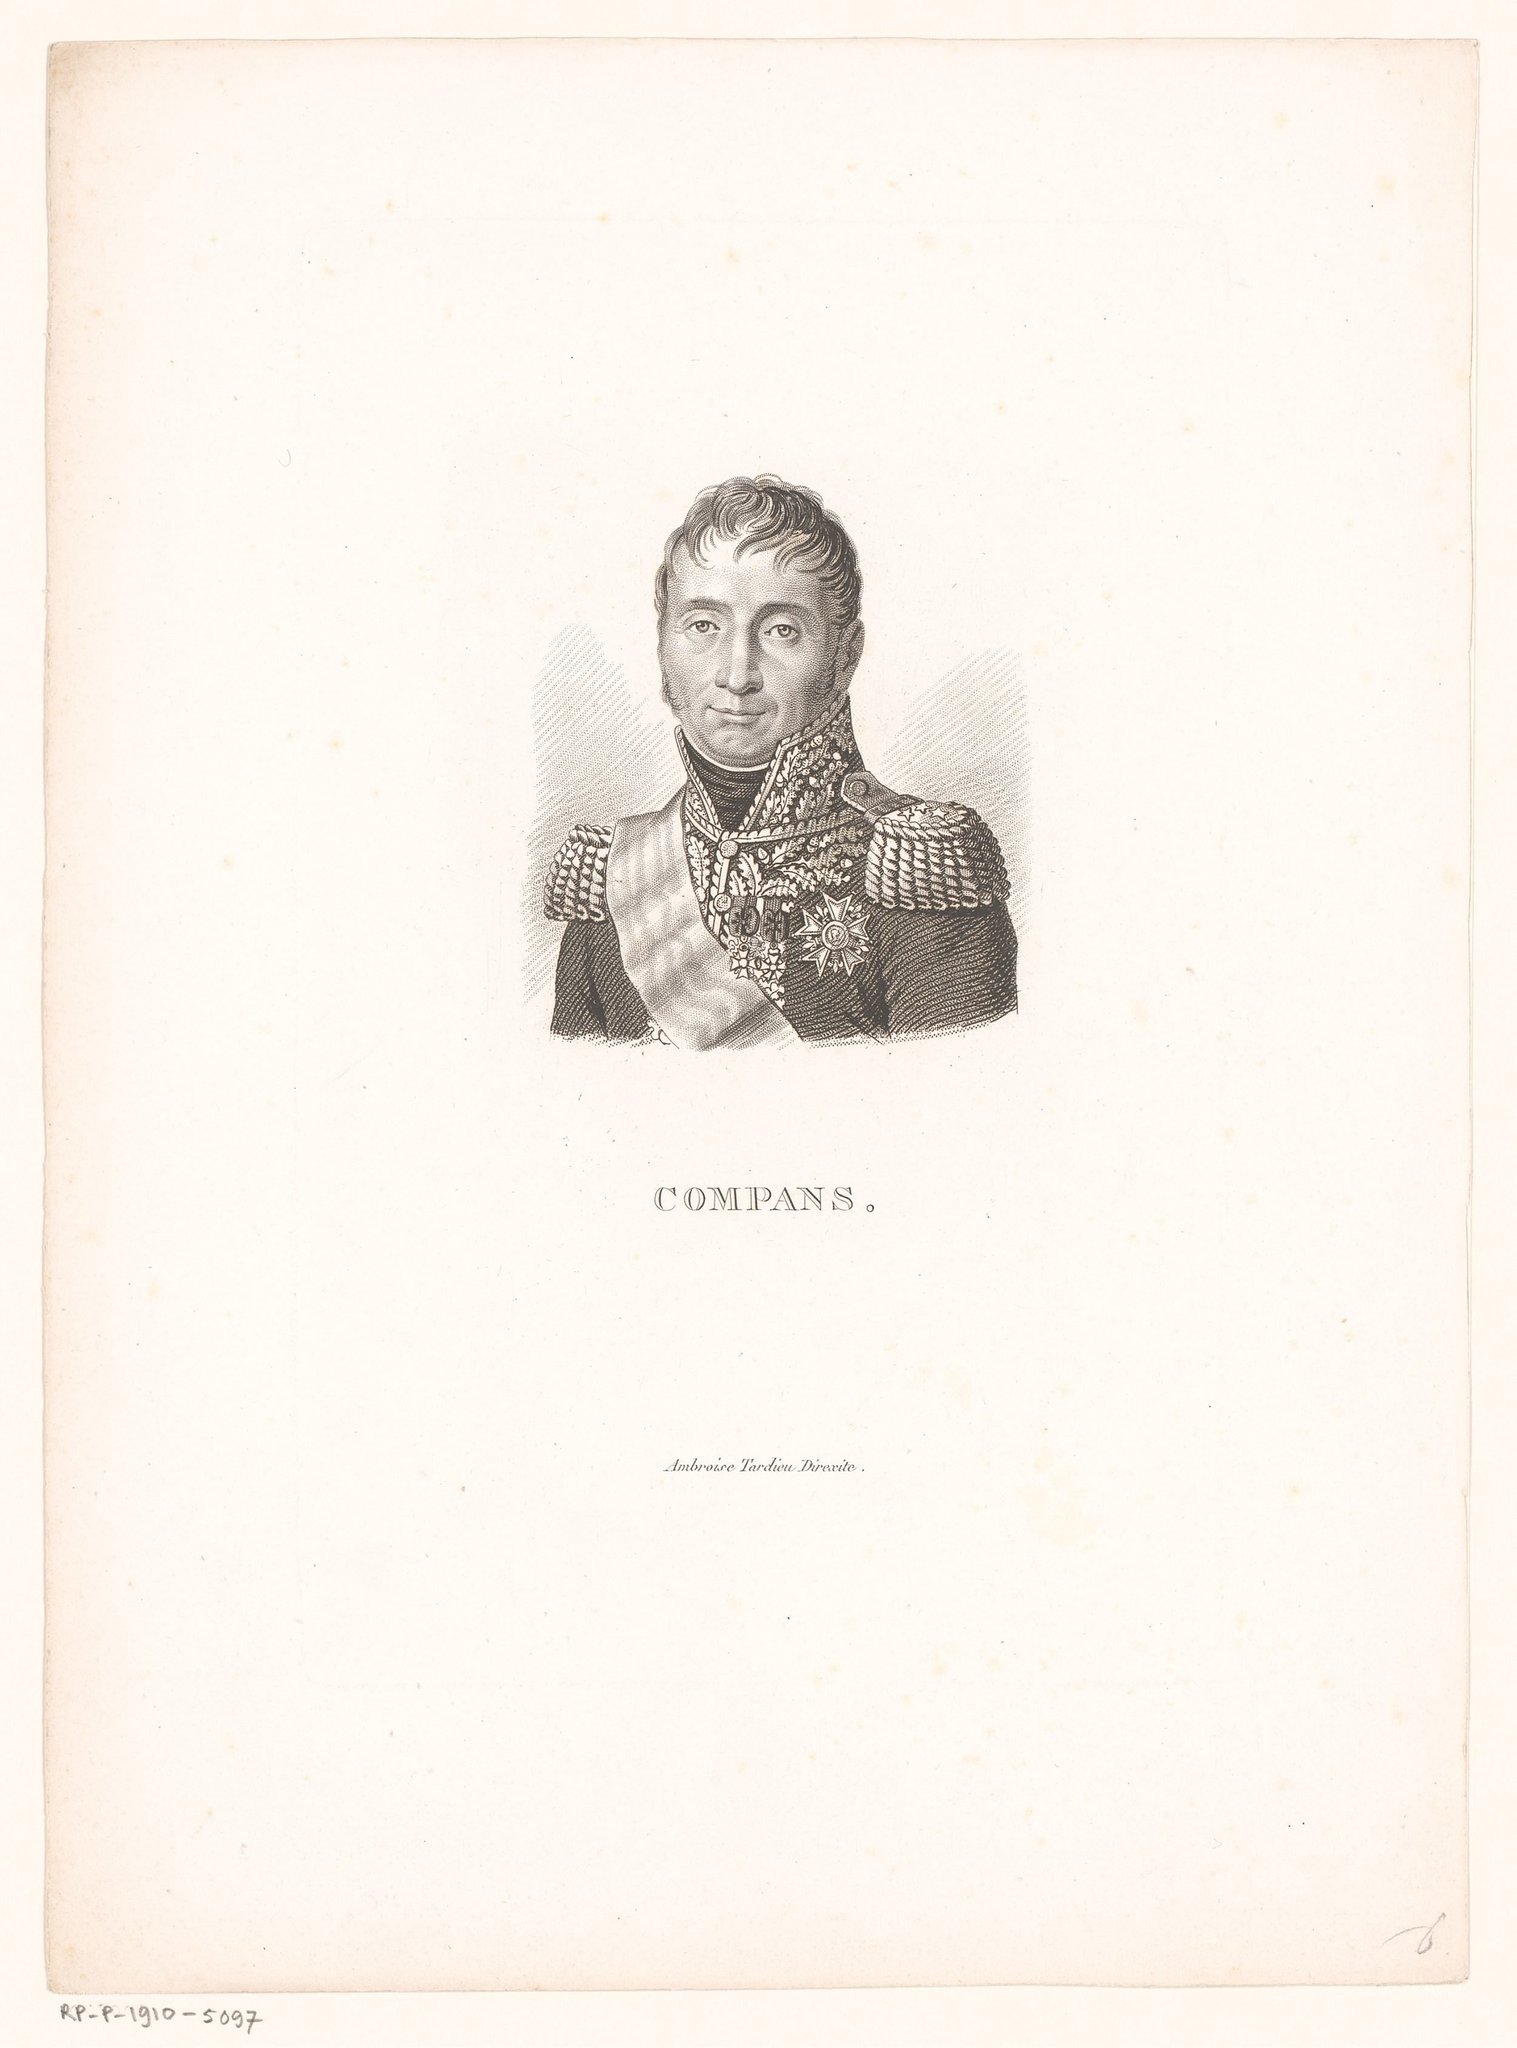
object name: book illustration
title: Portret van Jean Dominique Compans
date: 1818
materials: paper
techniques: etching, roulette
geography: paris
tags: commander-in-chief, general, marshal, historical persons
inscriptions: collector's mark: Lugt 2228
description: Mogelijk prent uit: Tardieu, Ambroise. Portraits des généraux français, faisant suite aux "Victoires et conquêtes des Français". Parijs: Panckoucke, Charles Louis Fleury, ca. 1818.